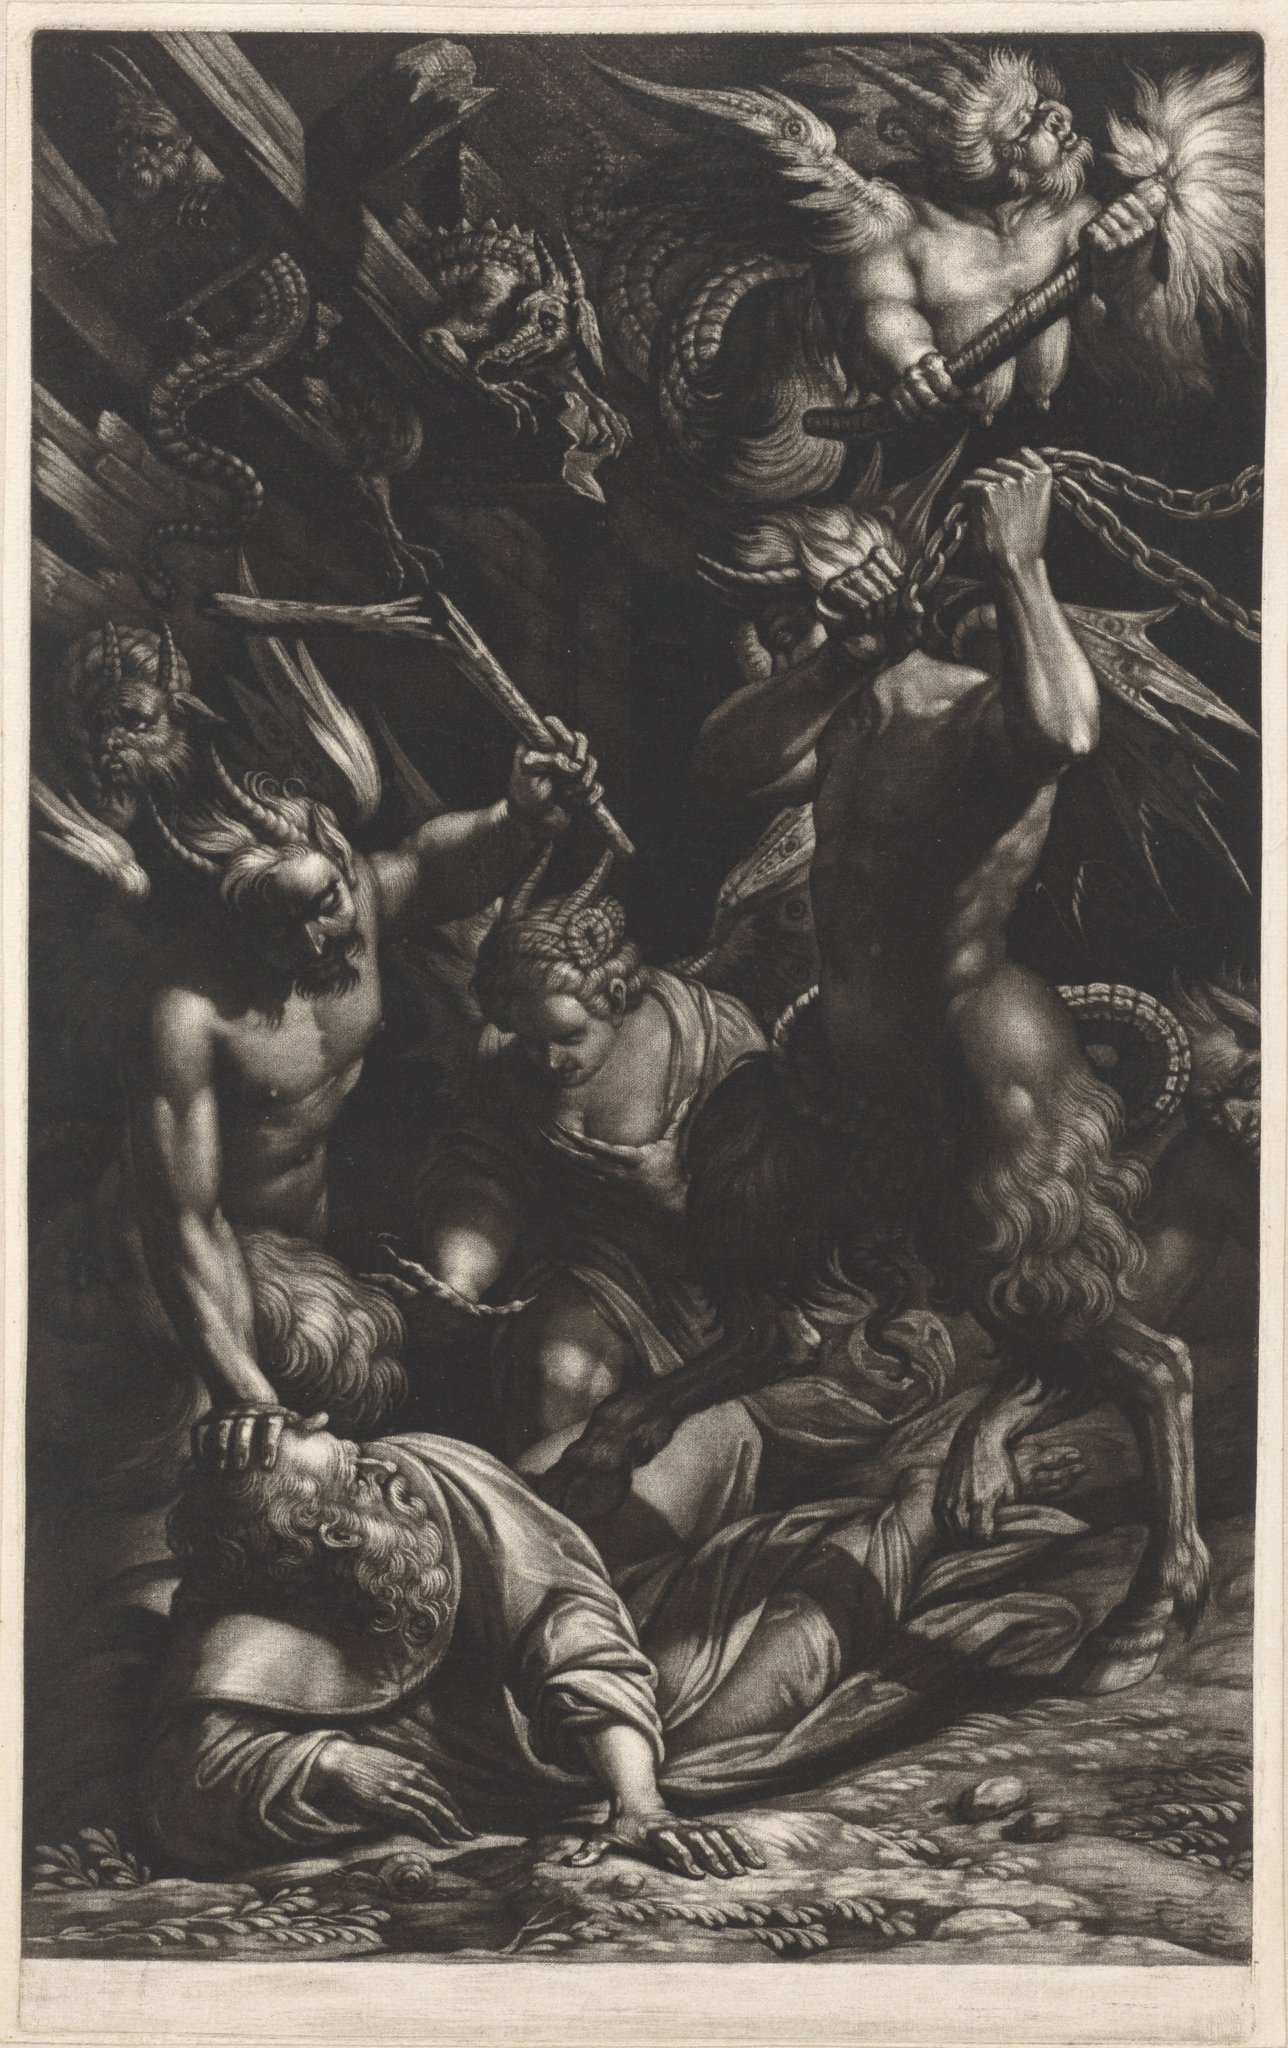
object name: print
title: Verzoeking van de heilige Antonius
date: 1665-1690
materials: paper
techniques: mezzotint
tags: personal devotion of st. antony abbot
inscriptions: collector's mark: Lugt 11, collector's mark: Lugt 10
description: De heilige Antonius ligt op de grond en wordt vastgehouden door een sater. Een tweede sater heft een ketting op om hem te slaan en een gevleugelde vrouw buigt zich over hem heen. In de lucht vliegen duivelse wezens.